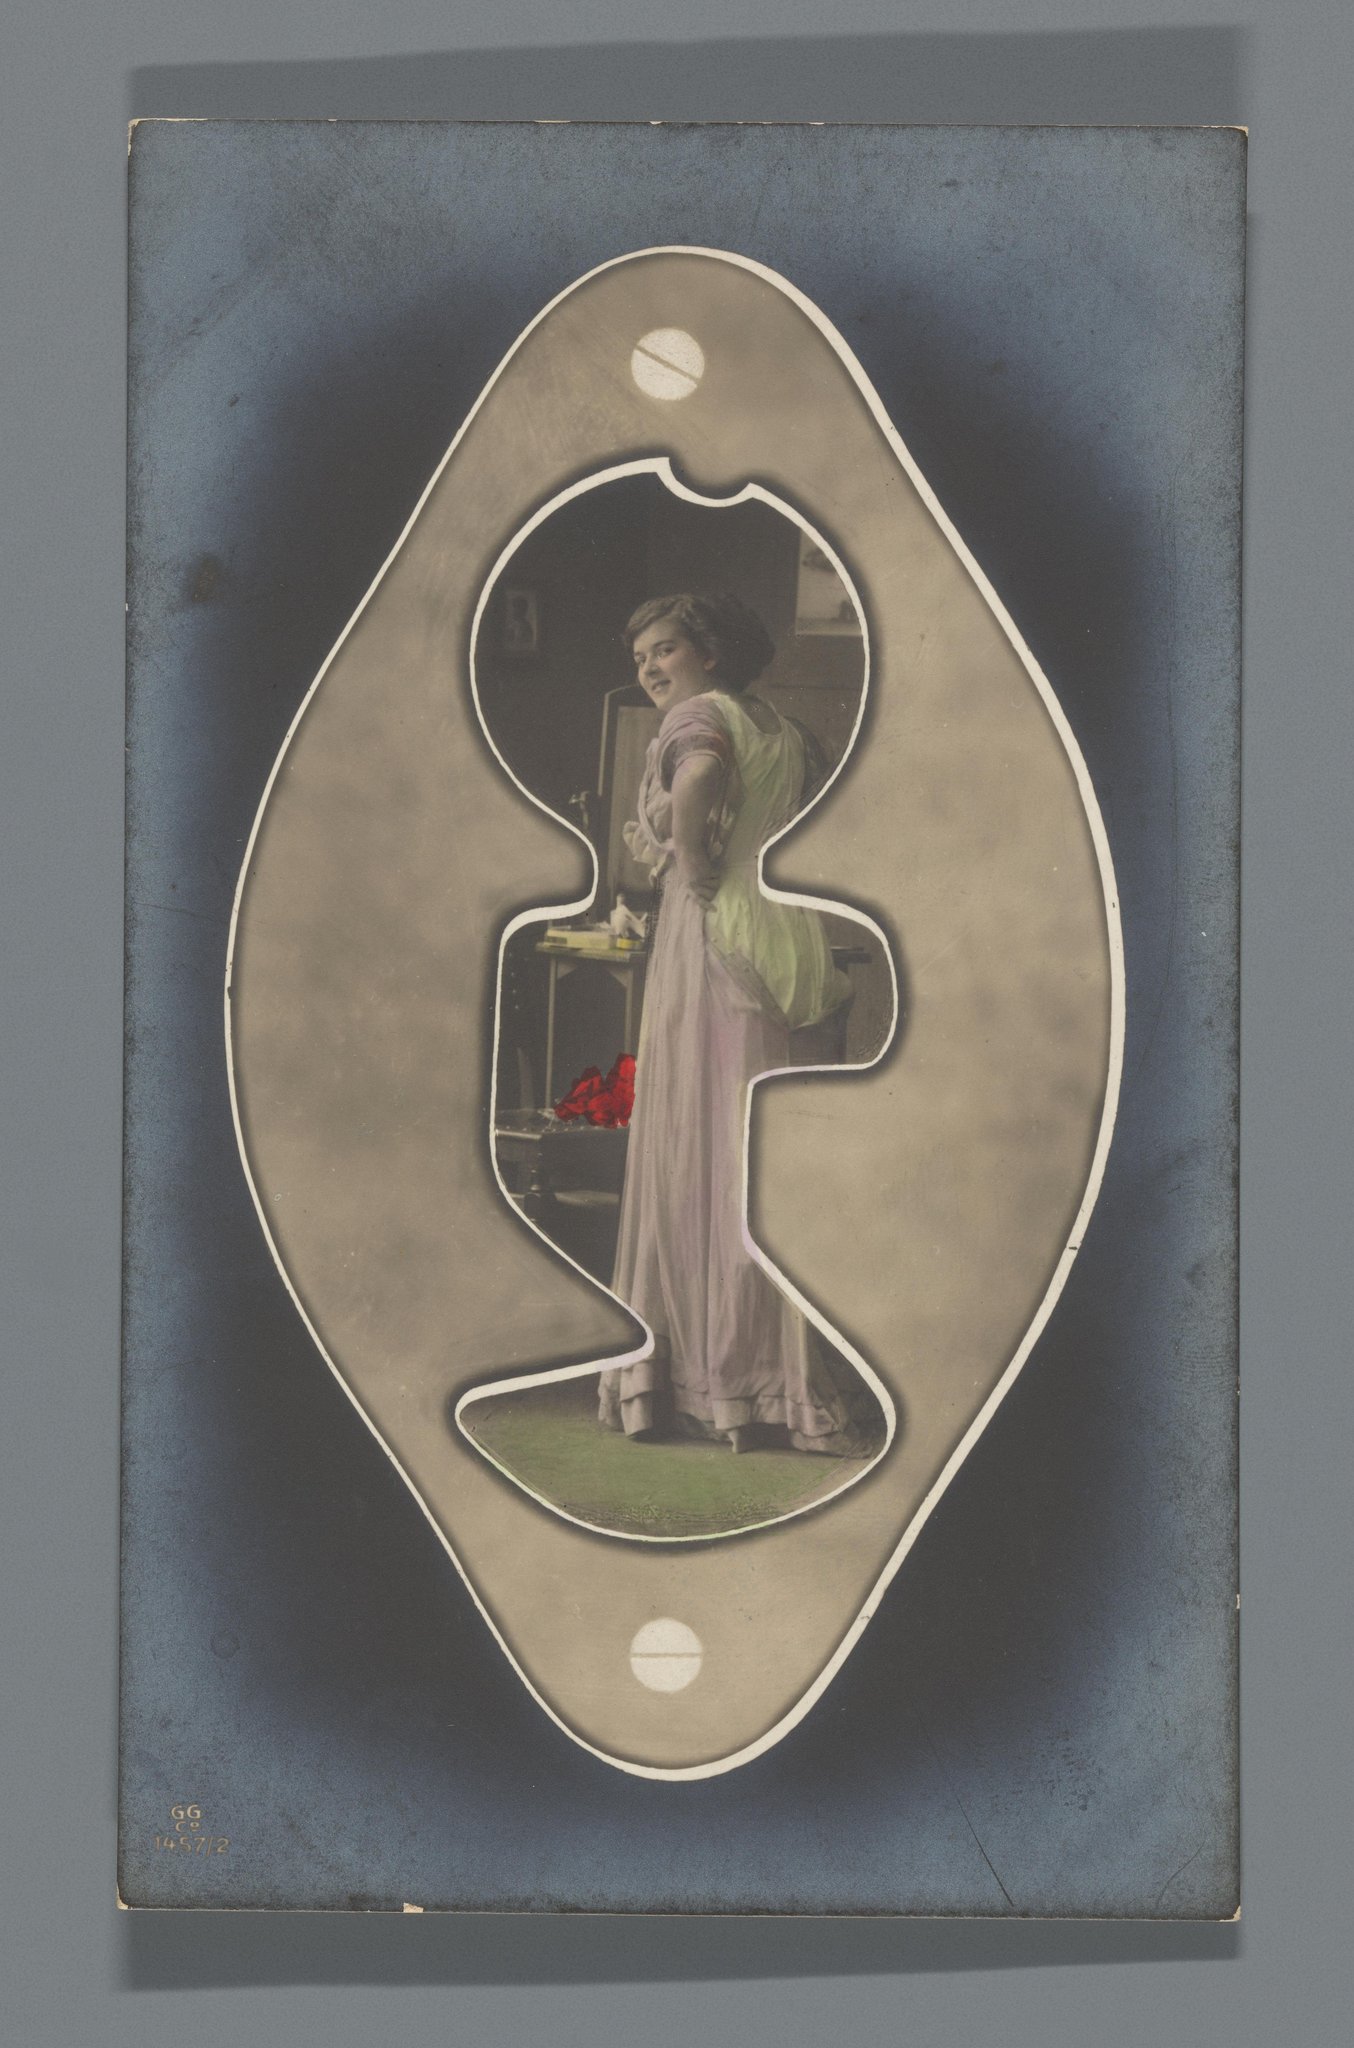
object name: ansichtkaart, prentbriefkaart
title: Vrouw die zich ontkleedt en opmaakt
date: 1920-1930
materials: paper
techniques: gelatin silver print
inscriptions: inscription: ‘GG / Co / 1457/2’, inscription: ‘P.R.A.’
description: Een van zes postkaarten/prentbriefkaarten met een voorstelling van een vrouw die zich ontkleedt en opmaakt, gezien door een sleutelgat.